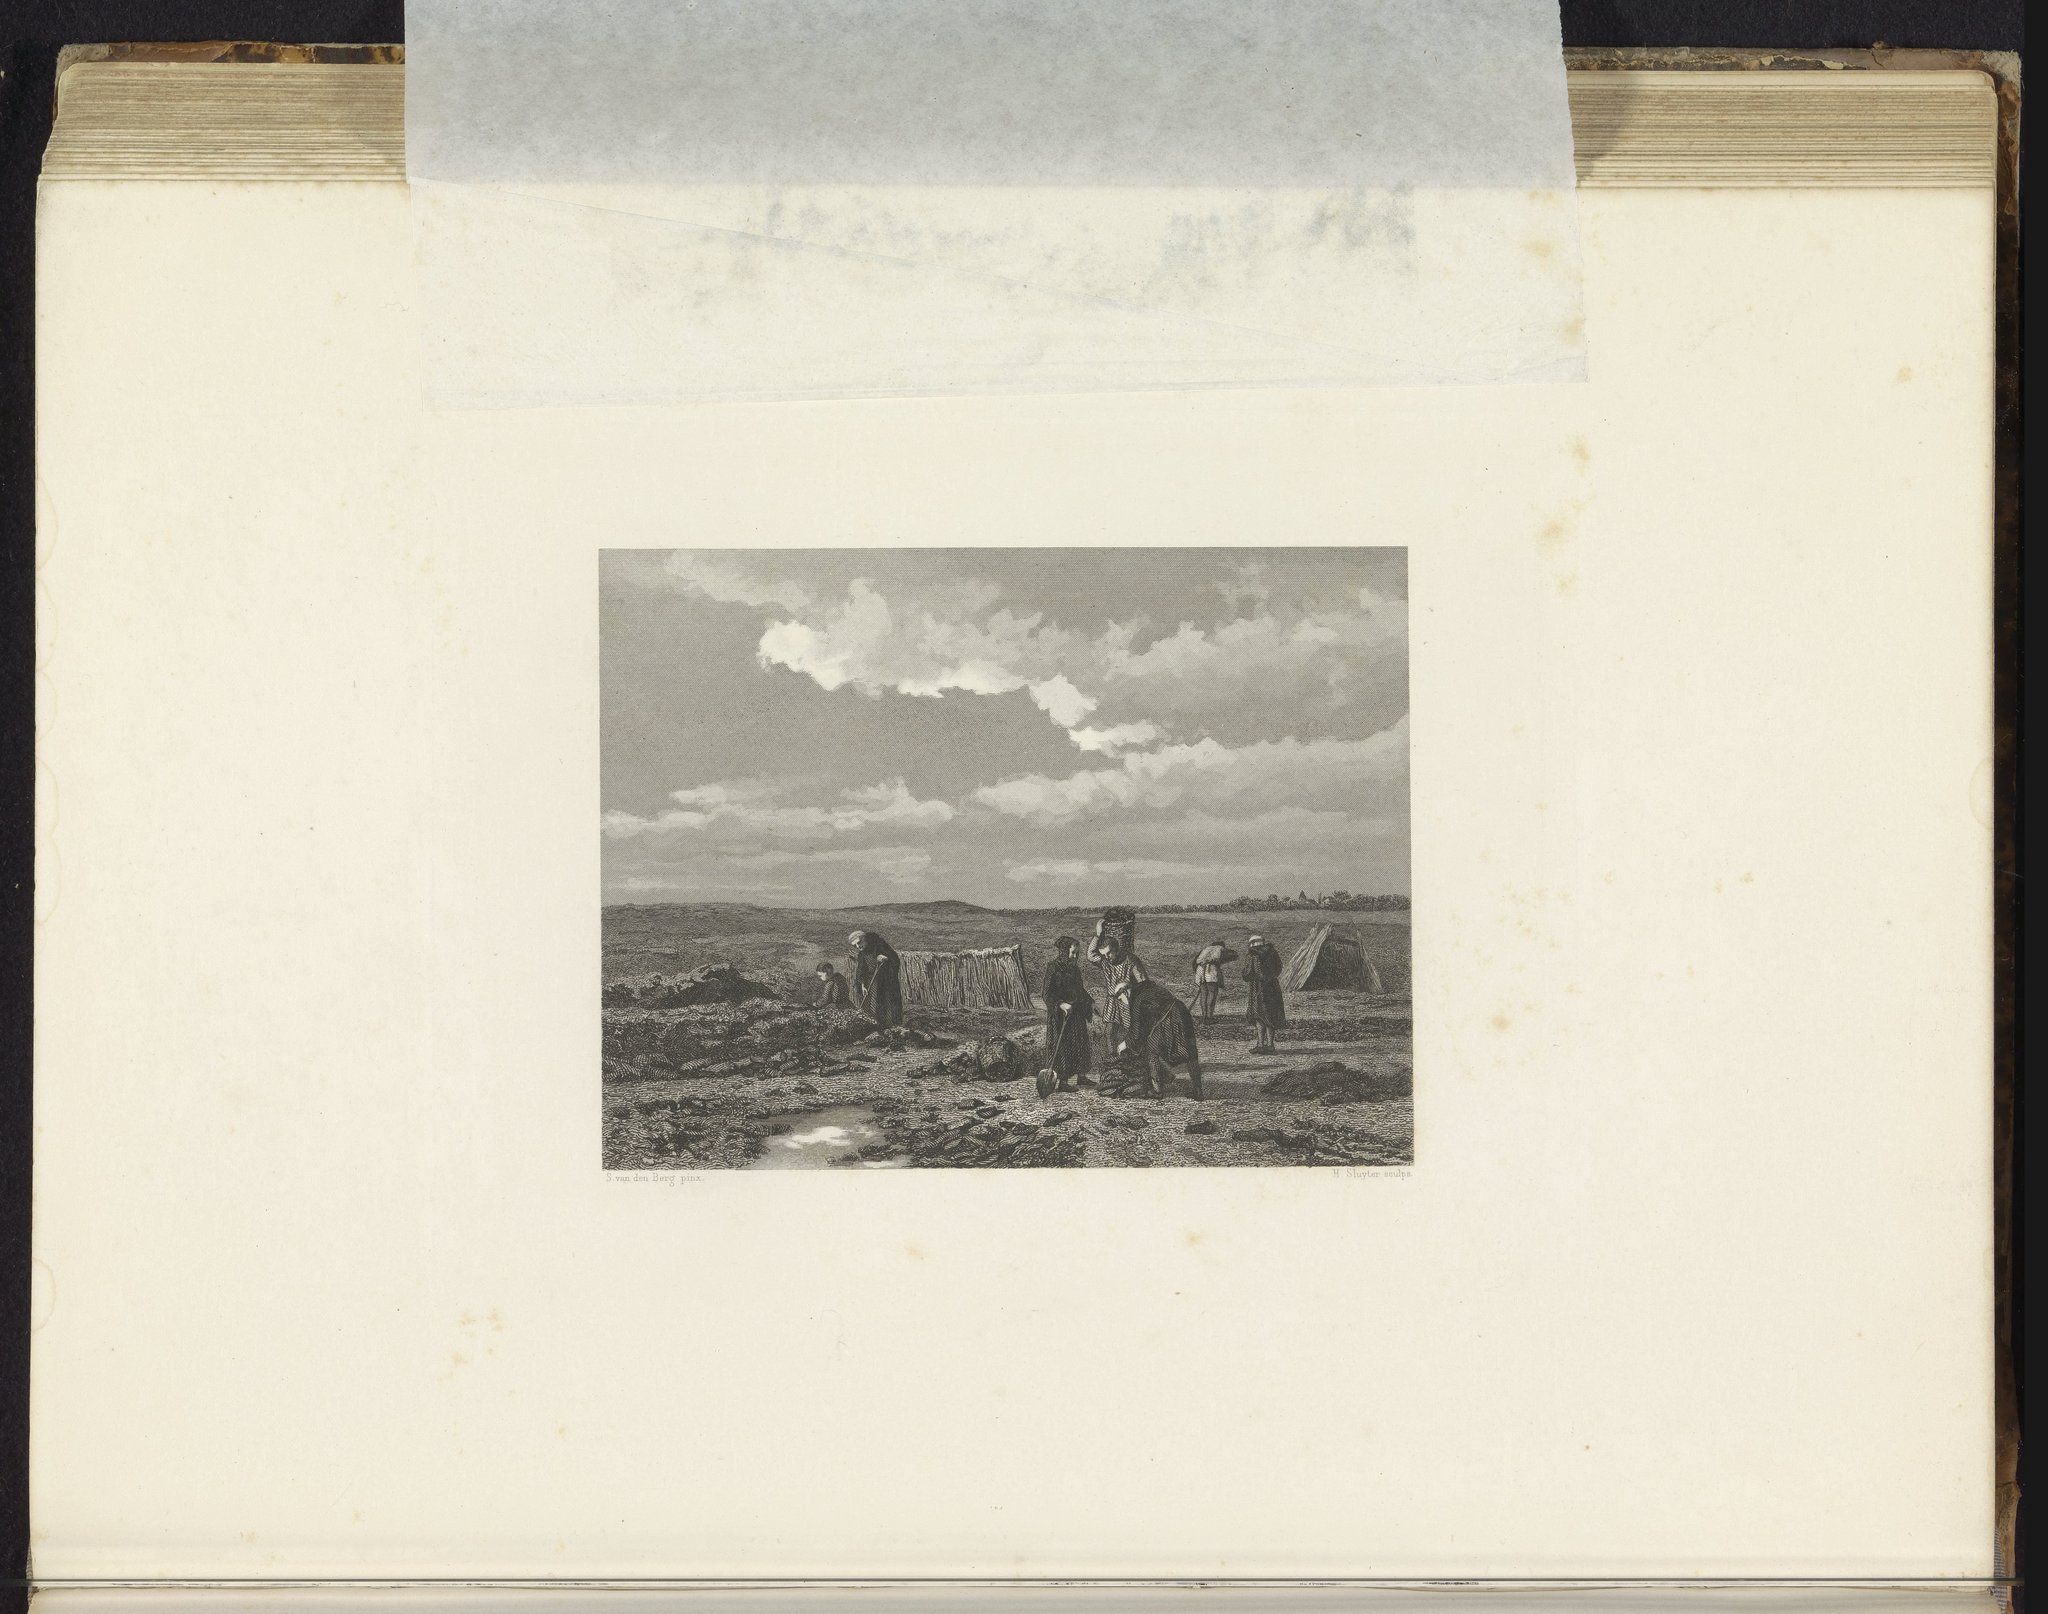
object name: history print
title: Monniken bevorderen de kunst der turfbereiding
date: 1865-1870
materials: paper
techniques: engraving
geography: netherlands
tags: peat-cutting, monk(s), friar(s), netherlands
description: Een groep van monniken houdt zich bezig met het steken van turf op het open land, ca. 1300. Onderdeel van de groep staalgravures naar de schilderijen van de Historische Galerij der Maatschappij Arti et Amicitiae.